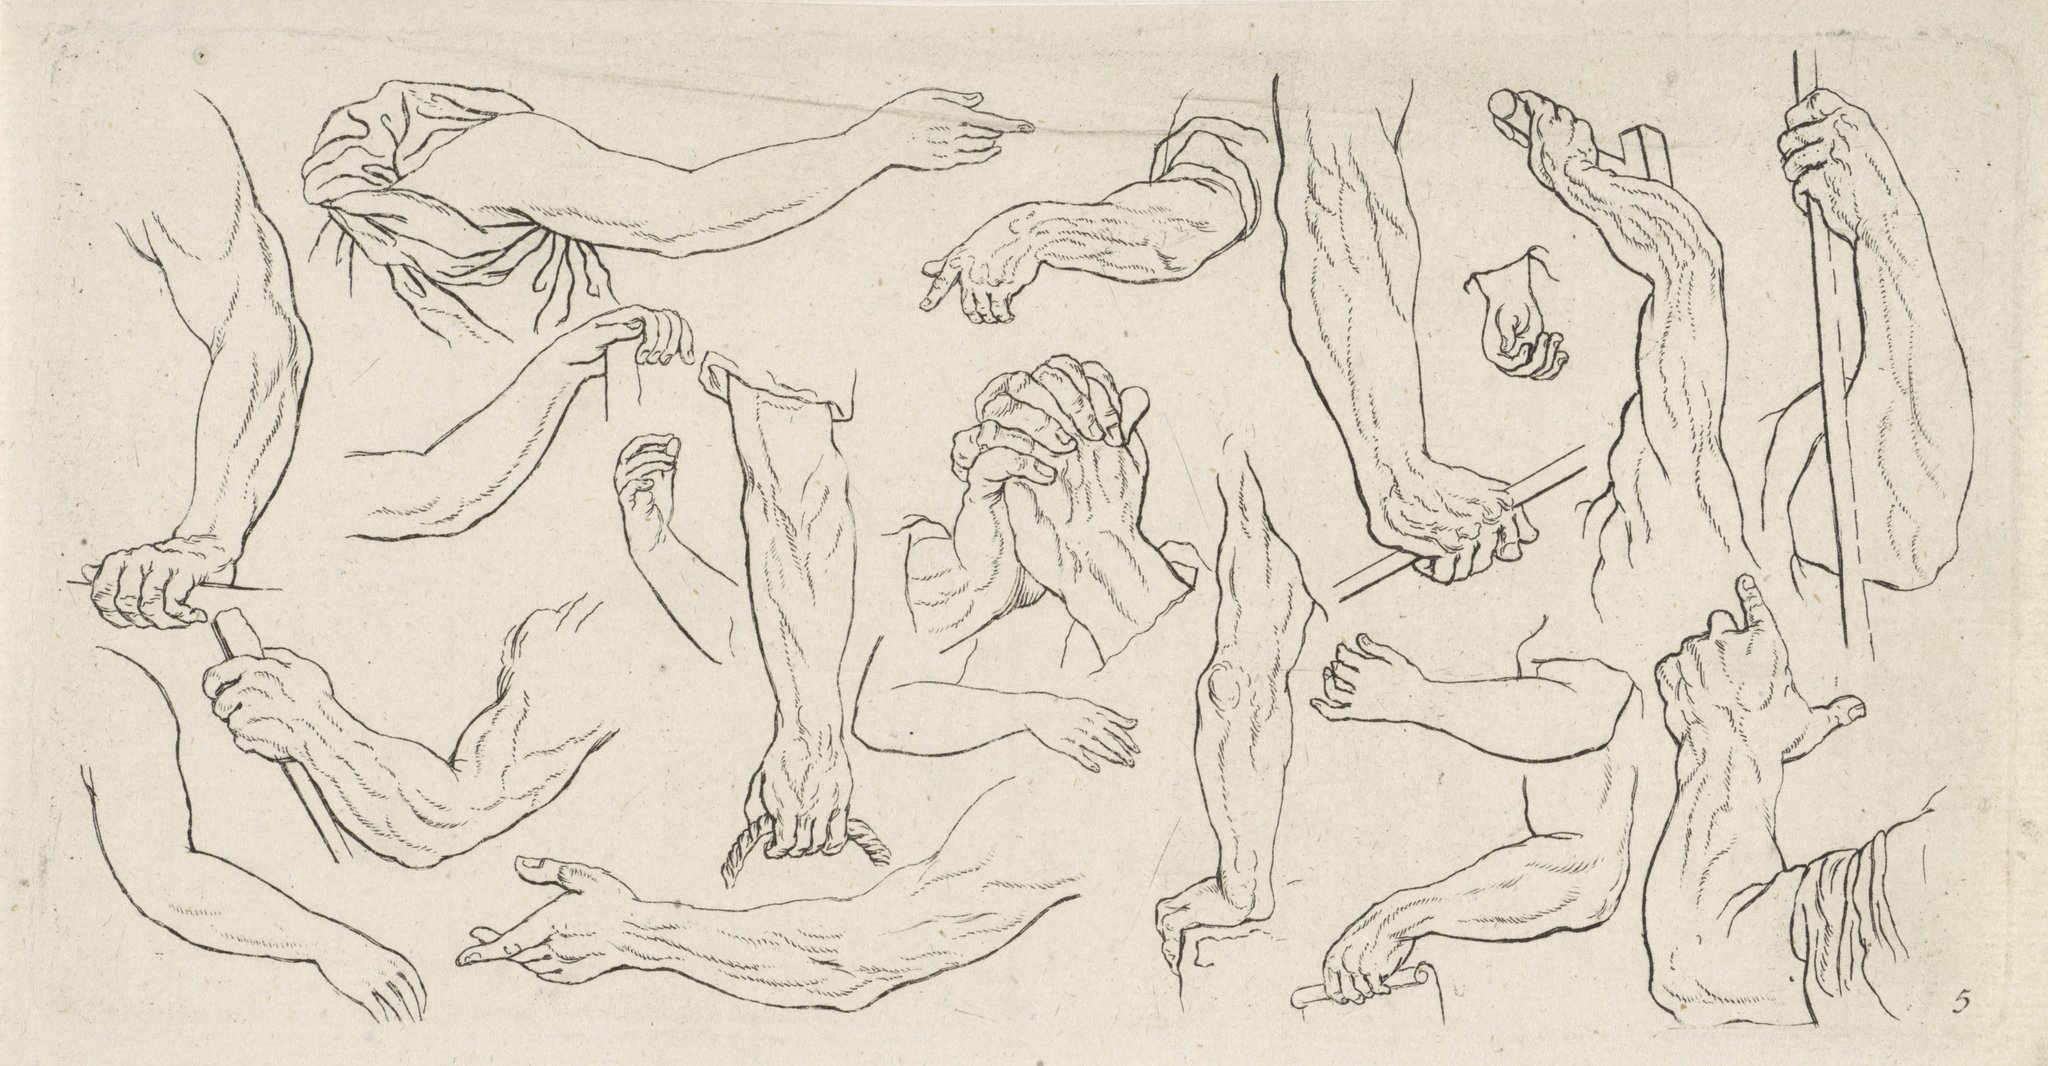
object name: print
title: Studies van menselijke figuren of lichaamsonderdelen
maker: leonard schenk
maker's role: print maker, publisher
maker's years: 1696-1767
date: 1710-1767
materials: paper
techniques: etching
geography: amsterdam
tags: arms - aa - female human figure, arms, hands folded with fingers knit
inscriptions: collector's mark: Lugt 2228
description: Verschillende aanzichten van menselijke armen of delen daarvan. Sommige handen houden een voorwerp vast en er is een paar gevouwen handen bij. De prent is afkomstig uit een serie van vermoedelijk twaalf studievoorbeelden voor jonge kunstenaars.